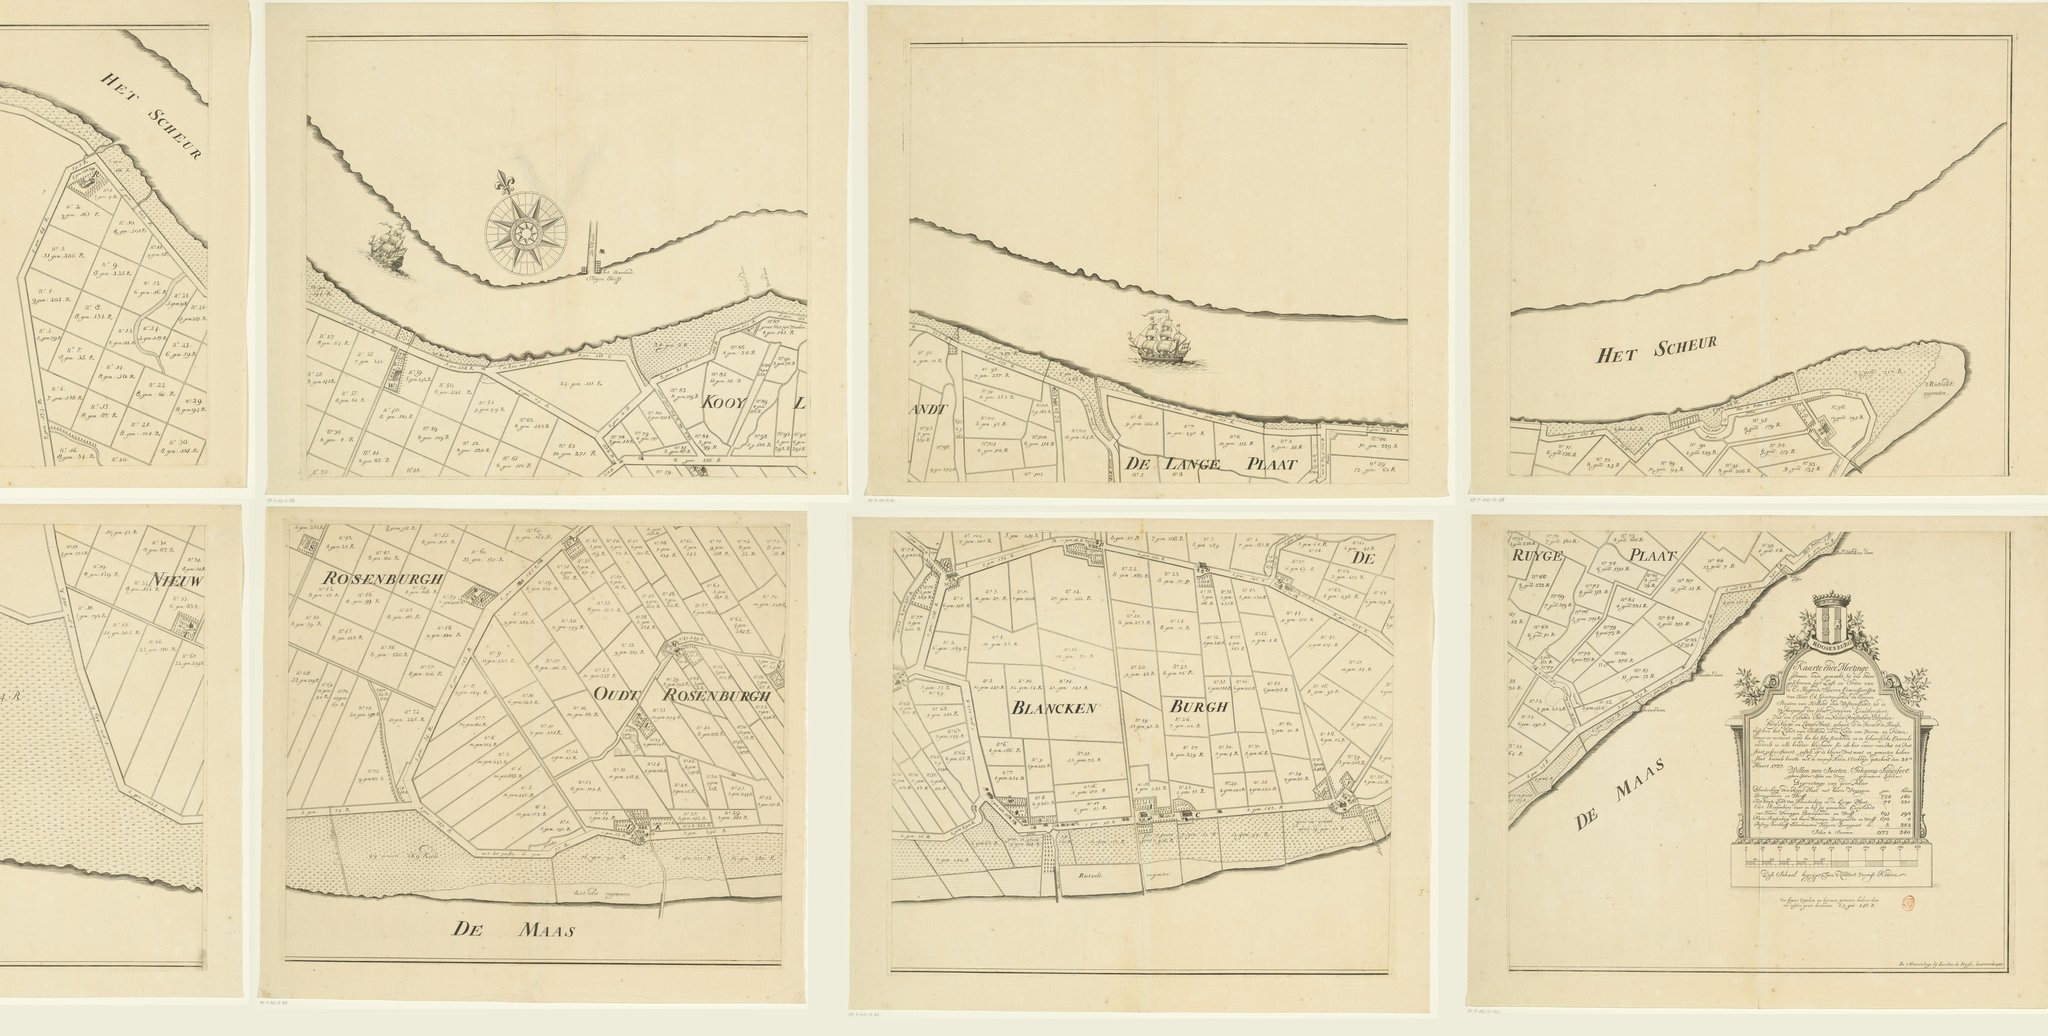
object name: map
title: Kaarte ende meetinge … van den eijlande Oudt en Nieuw Roosenburg, Blankenburg, Ruijge, en Lange Plaat, gelegen in de reviere de Maase, tusschen het landt van Holland, en de lande van Voorne en Putten …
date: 1727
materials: paper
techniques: engraving, etching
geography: the hague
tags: coat of arms (as symbol of the state, etc.) (+ city; municipal), maps of separate countries or regions, polder, reclaimed land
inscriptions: collector's mark: Lugt 195, collector's mark: Lugt 195, collector's mark: Lugt 2228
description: Dit object is omwille van een betere presentatie virtueel samengevoegd maar bestaat fysiek uit losse onderdelen. De lijst met de namen van de kopers van de genummerde percelen op de kaart is gedrukt onder de titel 'Staat van het Eylandt Rosenburgh, soo wegens Revenuen, Lasten als Kooppenningen. Verkoght den 16 Mey 1727'. Exemplaren van deze lijst zijn te vinden in het Nationaal Archief te Den Haag en de Universiteitsbibliotheek Leiden. Voor een naar deze kaart getekende kaart, zie RP-T-AO-13-9.